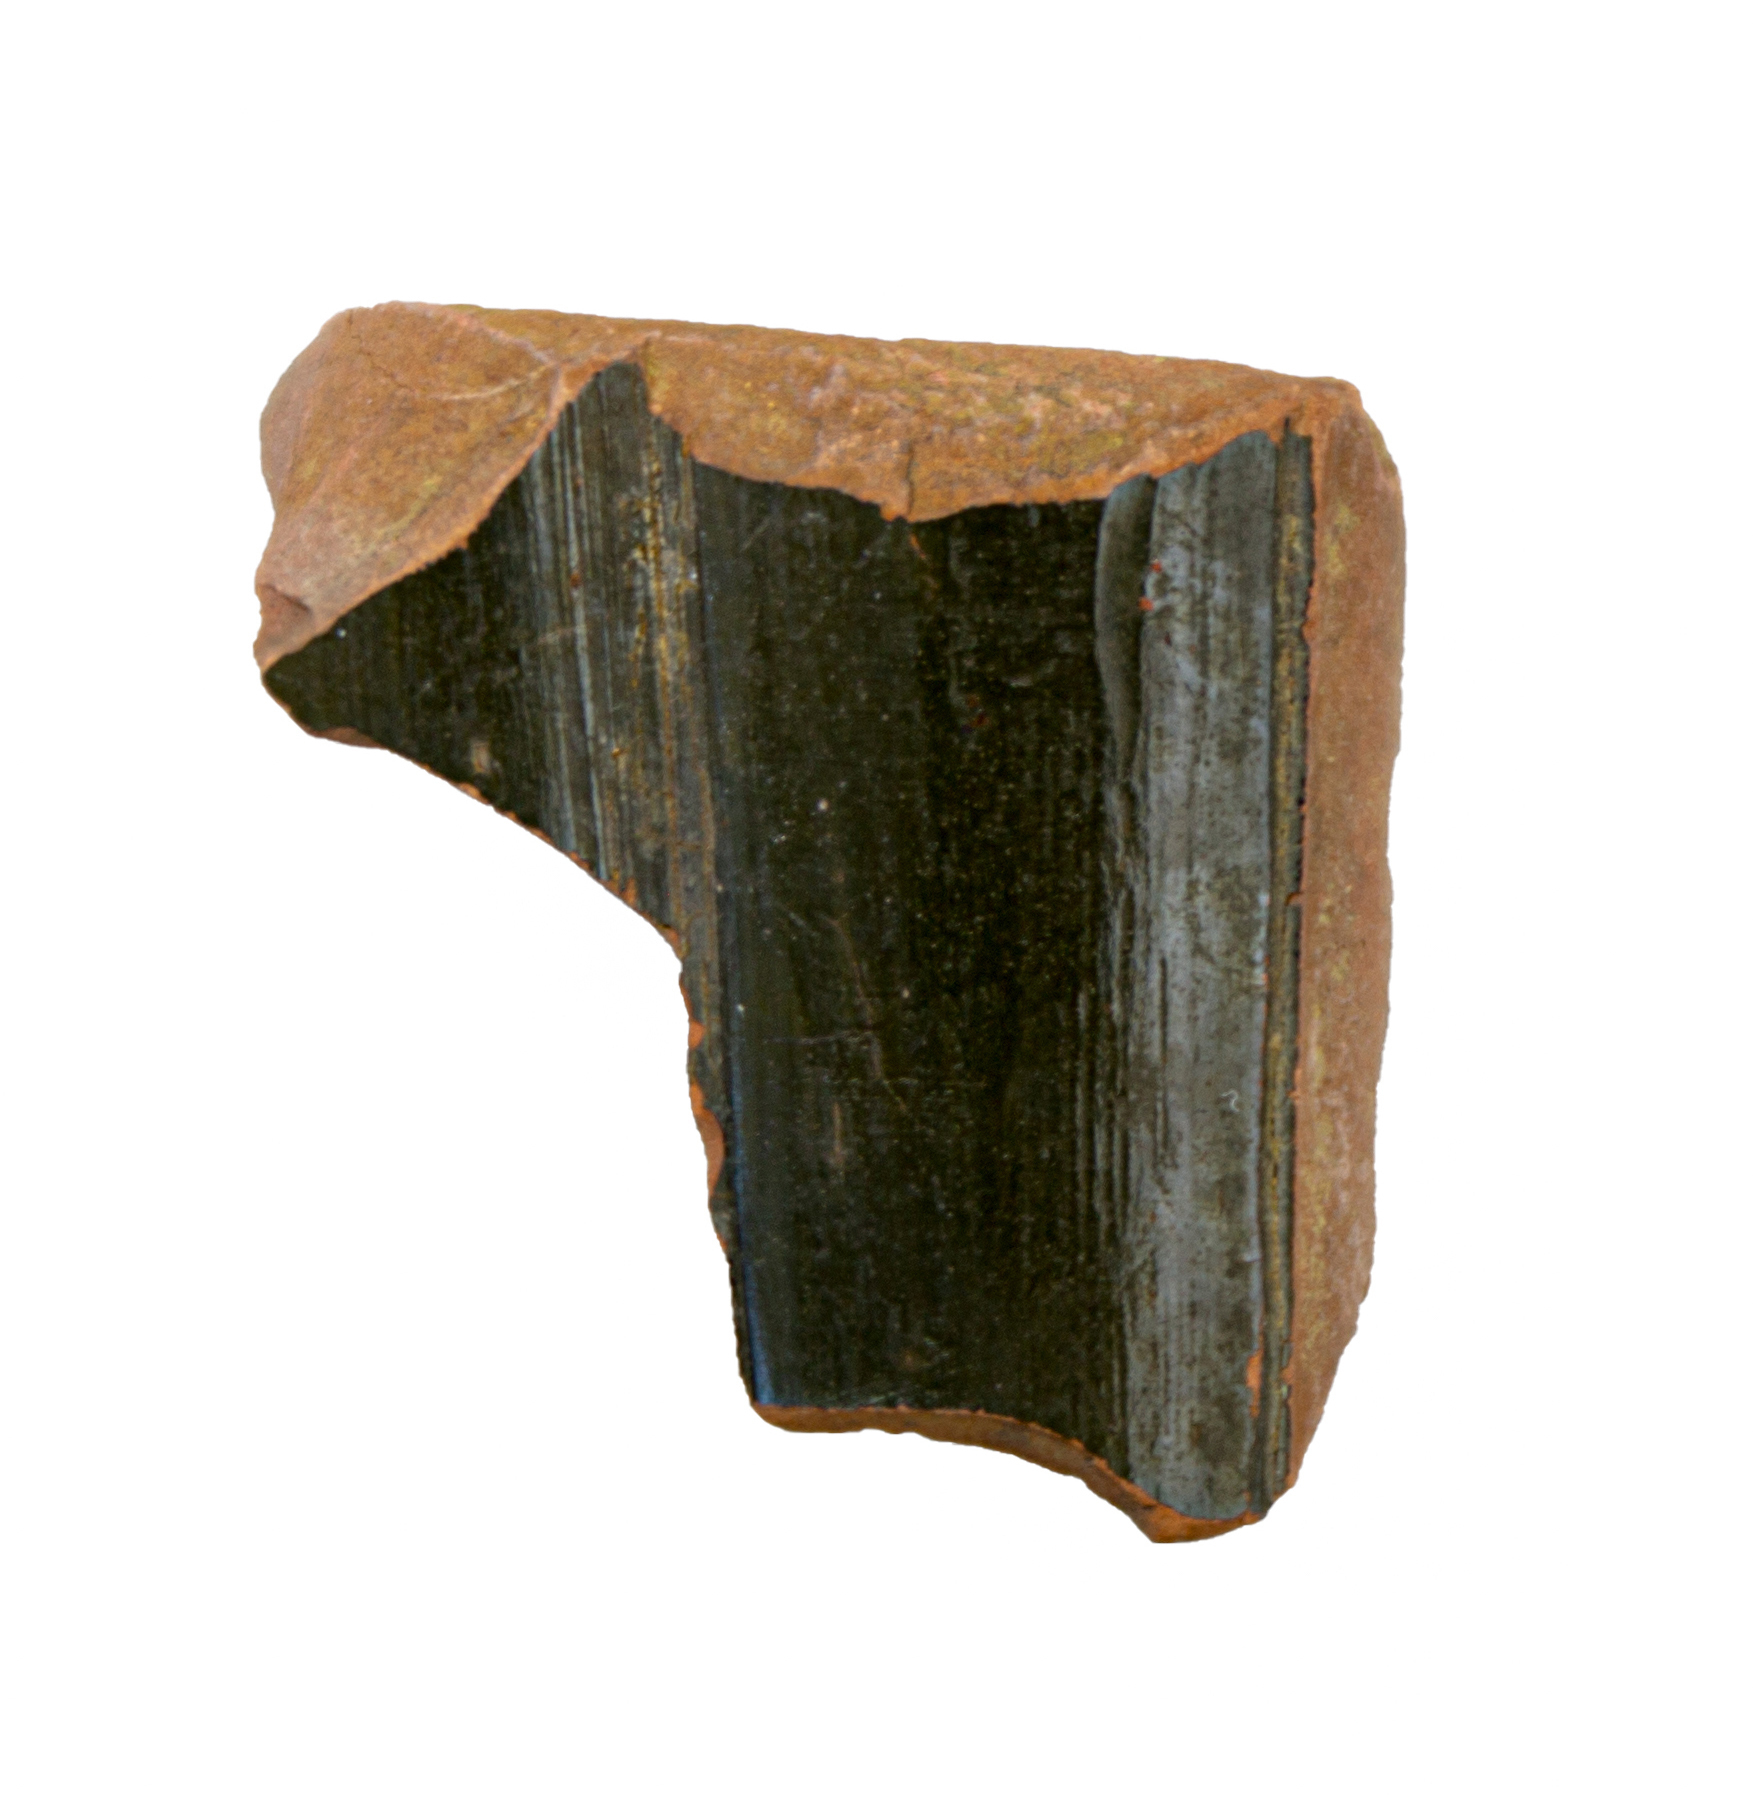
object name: volute krater fragment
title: Volute-krater fragment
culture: greek, south italian, apulian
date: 400-301 BCE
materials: terracotta